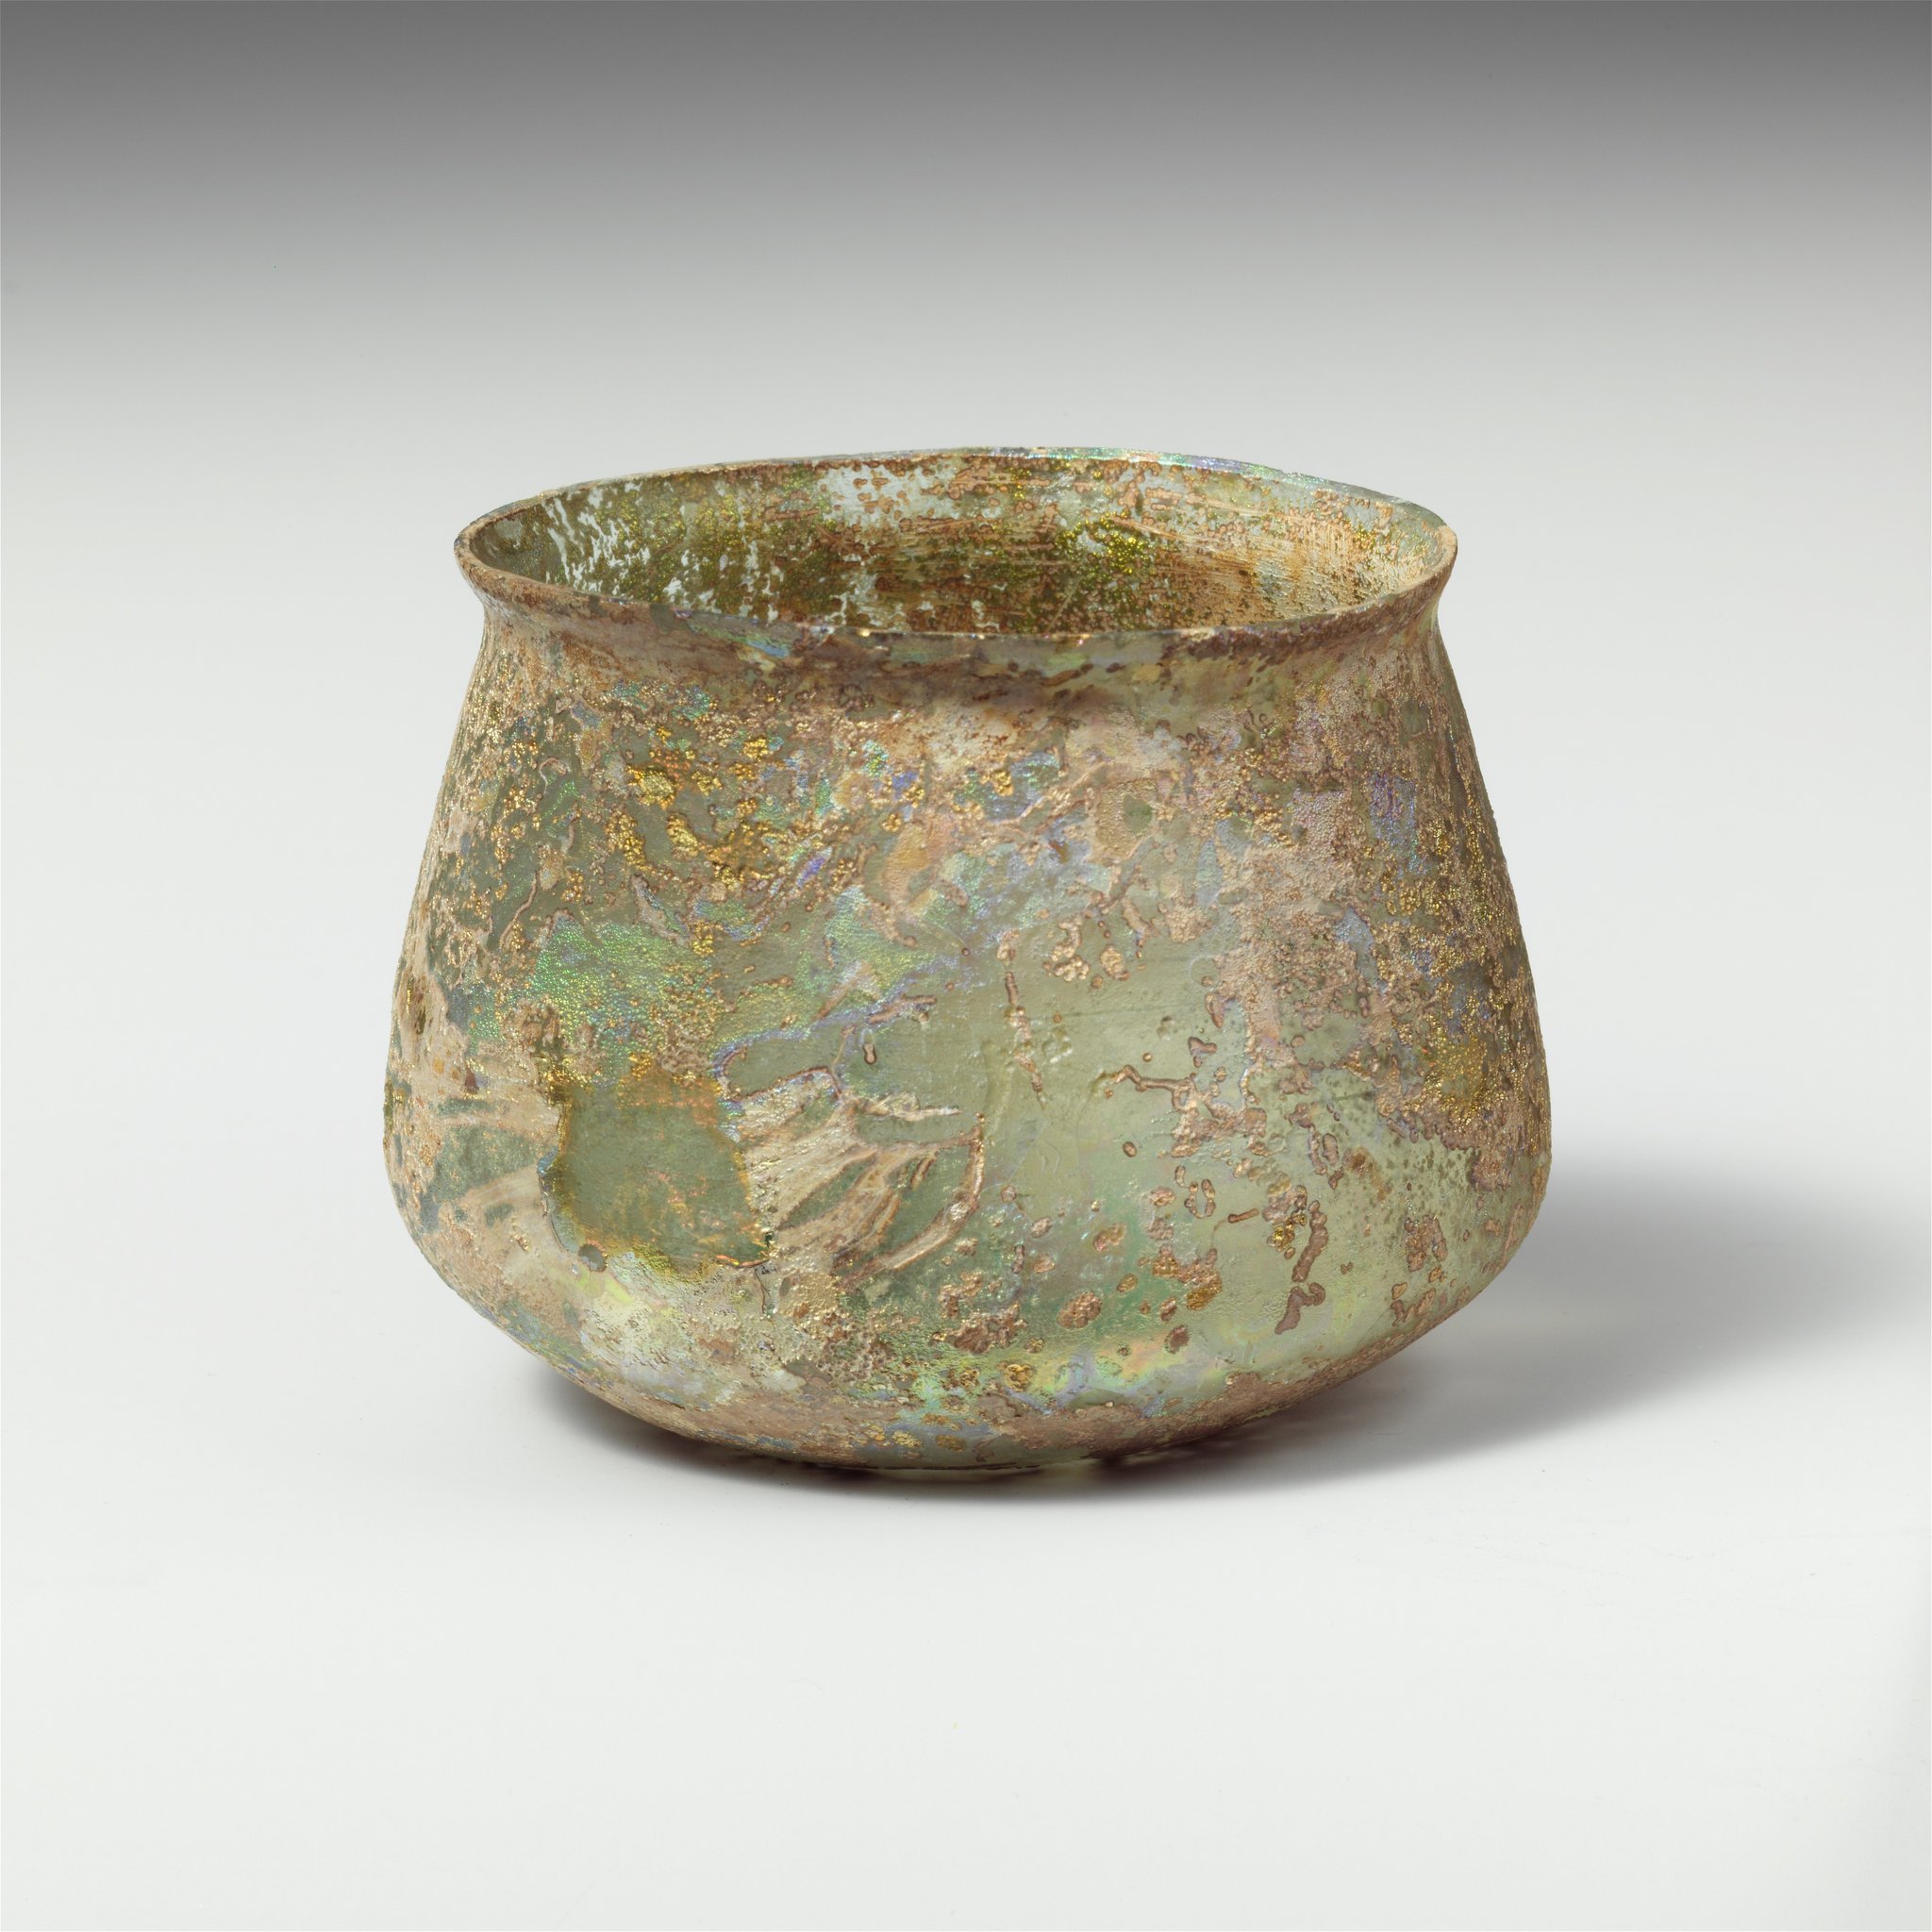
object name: cup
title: Glass cup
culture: roman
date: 101-300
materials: glass